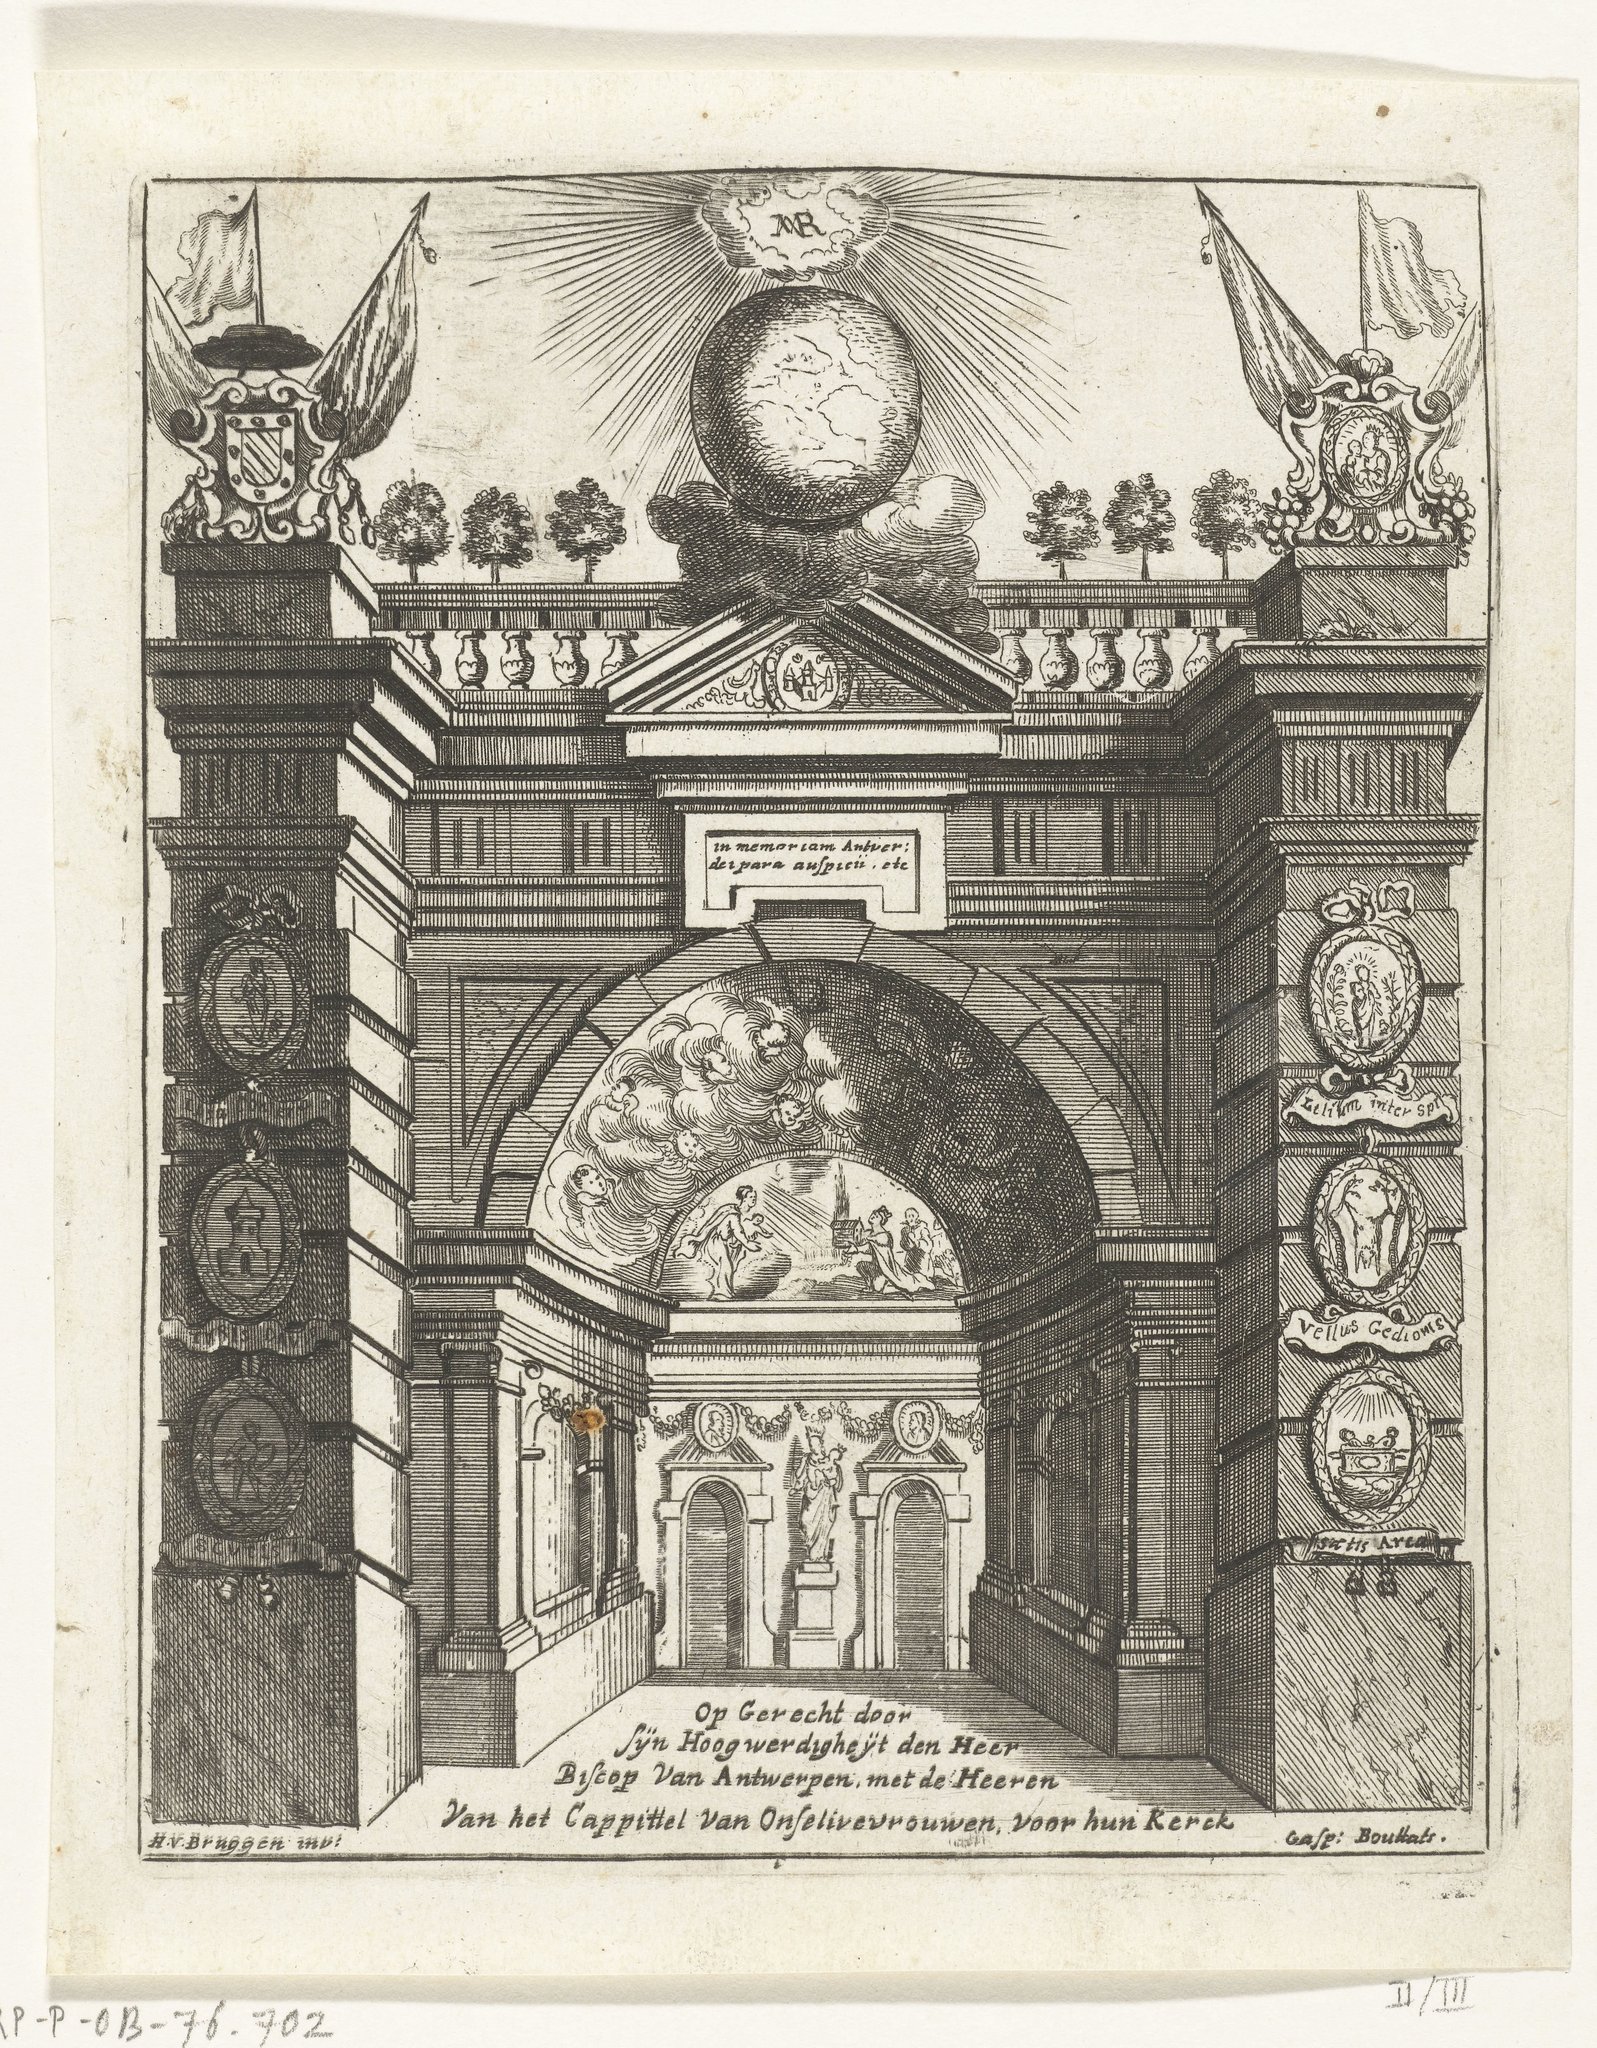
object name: print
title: Triomfpoort opgericht door de bisschop van Antwerpen voor de Onze-Lieve-Vrouwekathedraal, 1685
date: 1685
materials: paper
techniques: etching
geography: southern netherlands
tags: triumphal arch, antwerp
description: Gebruikt als illustratie in: Hondert-jaerigh jubile-vreught bewesen in dese stadt Antwerpen ter oorsaecke vande herstellinge des geloofs in't jaer 1585. door de glorieuse waepenen van sijne catholijcke majesteyt, onder t'beleyt van ... Alexander Farnesius ... / Ghemaeckt ende by-een vergadert door ... Petrus Franciscus de Smidt, Hieronymus Verdussen den jonghere, Antwerpen 1685.